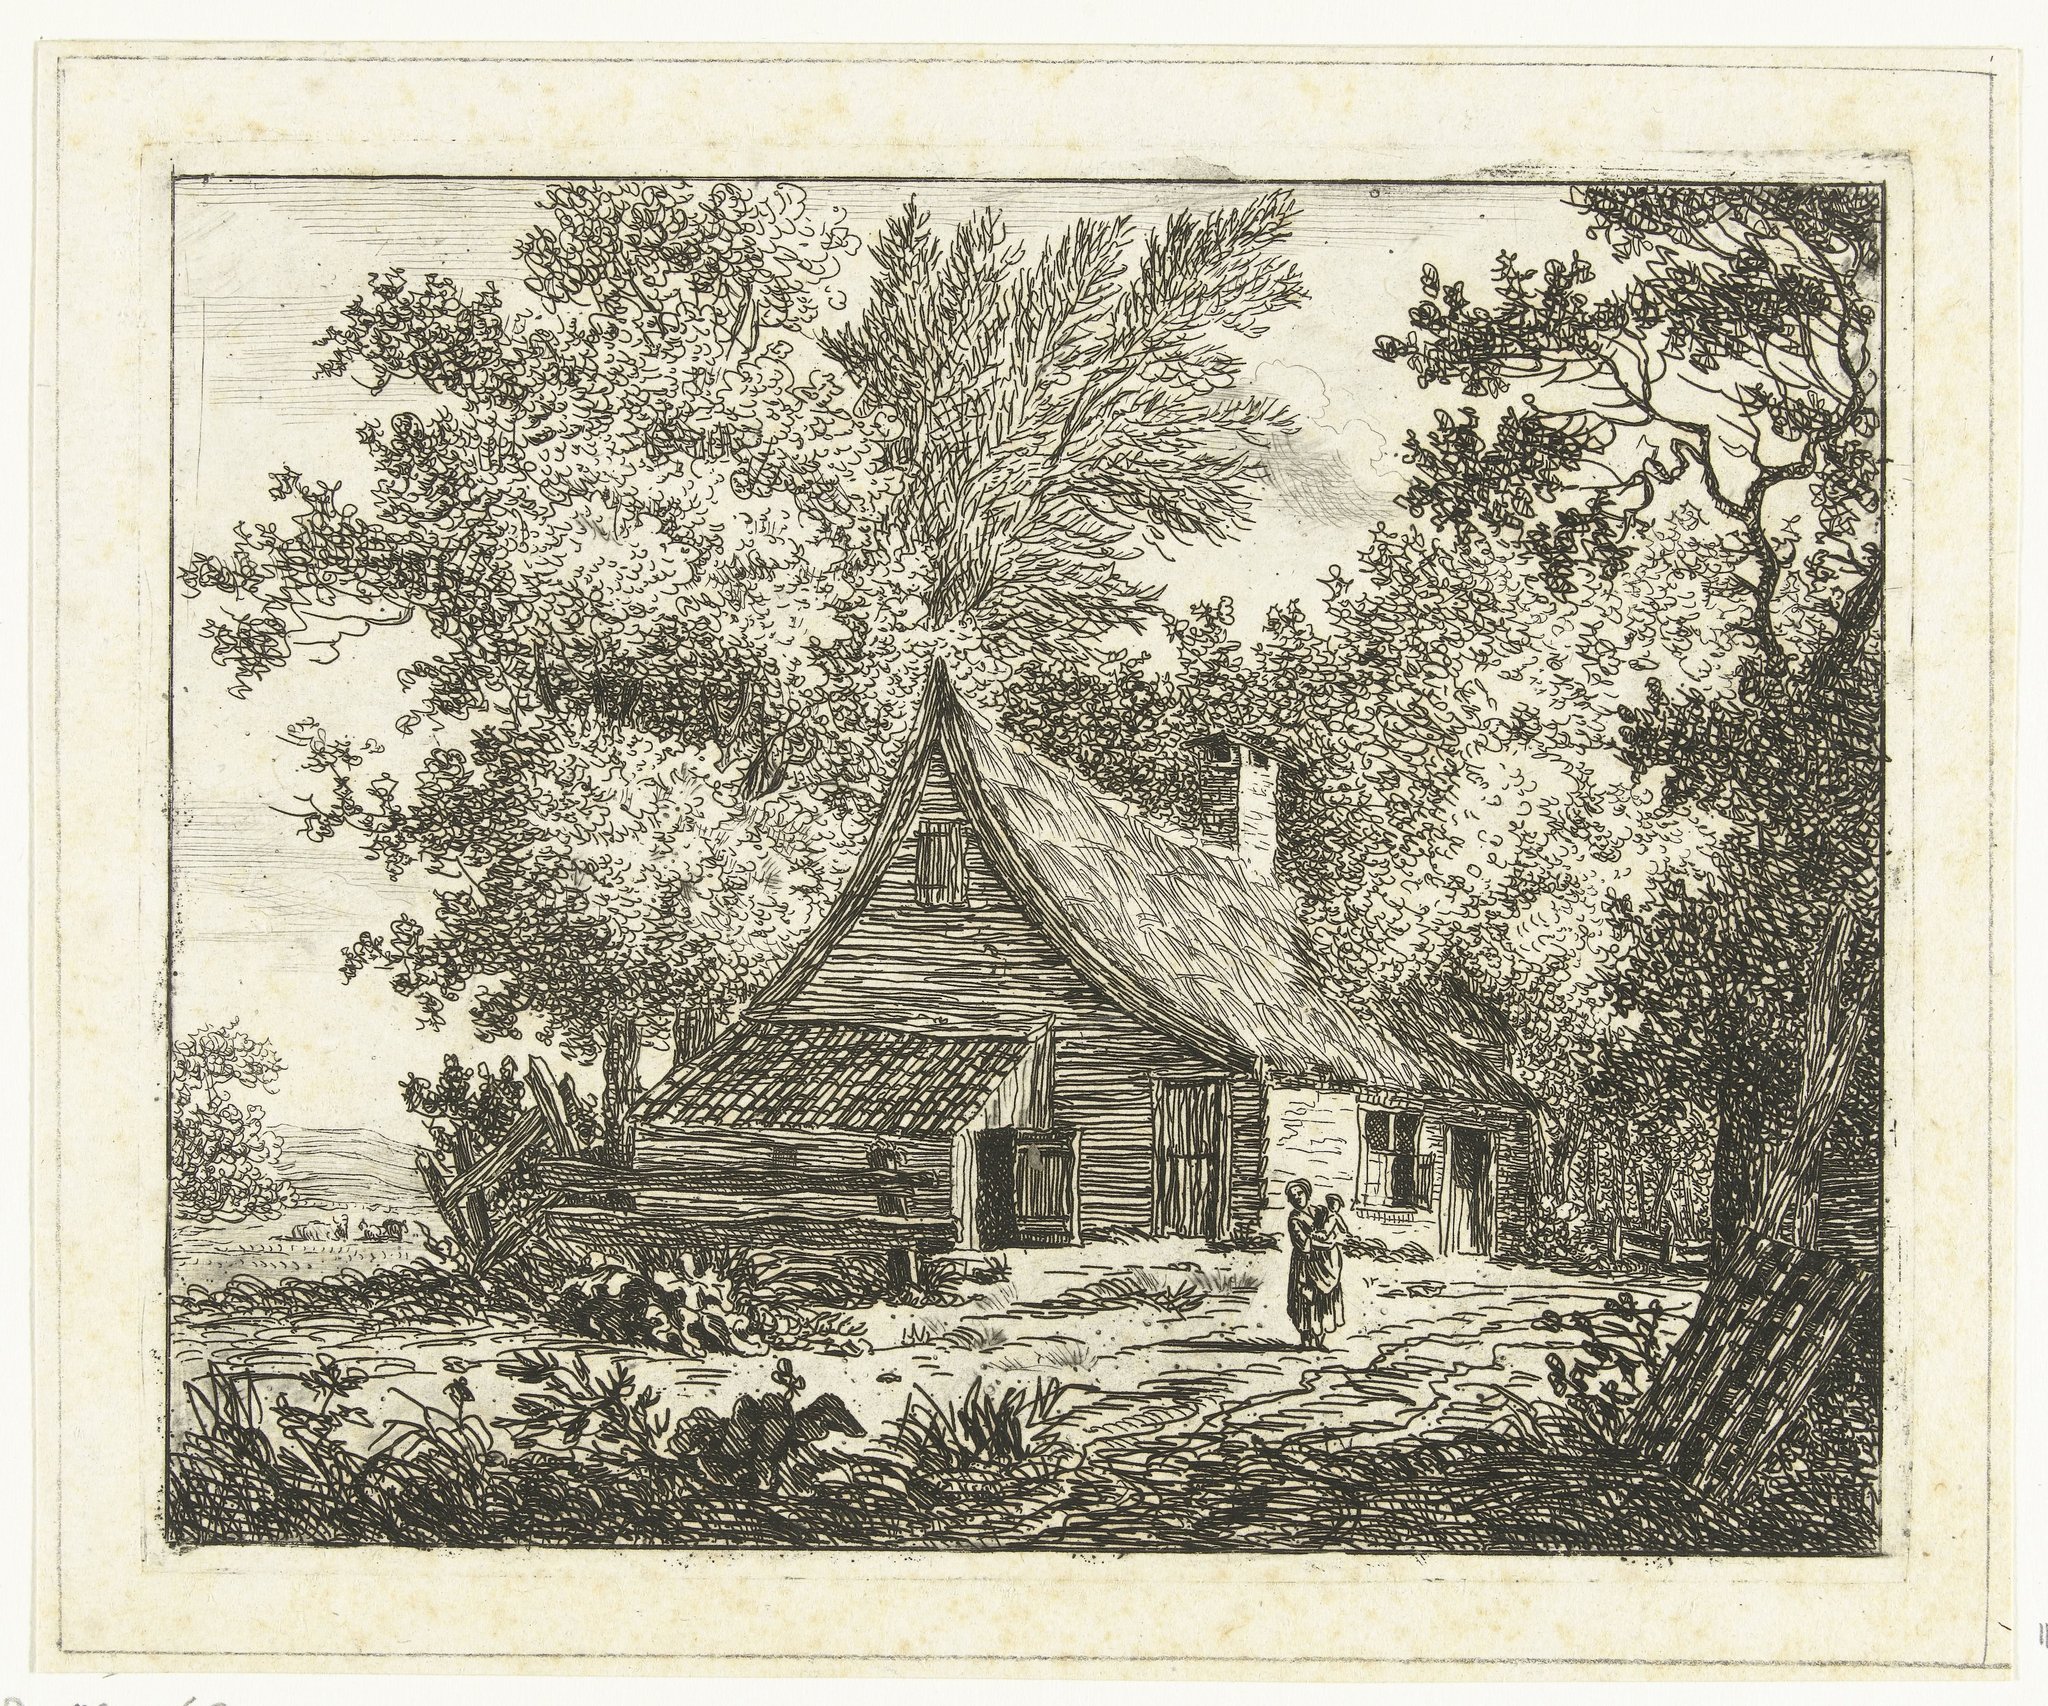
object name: print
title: Vrouw met kind staande voor een boerderij op de Amstelveense Weg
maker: anthonie van den bos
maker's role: draughtsman, print maker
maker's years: 1763-1838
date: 1778-1838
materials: paper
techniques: etching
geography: netherlands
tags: farm or solitary house in landscape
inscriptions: collector's mark: Lugt 2228